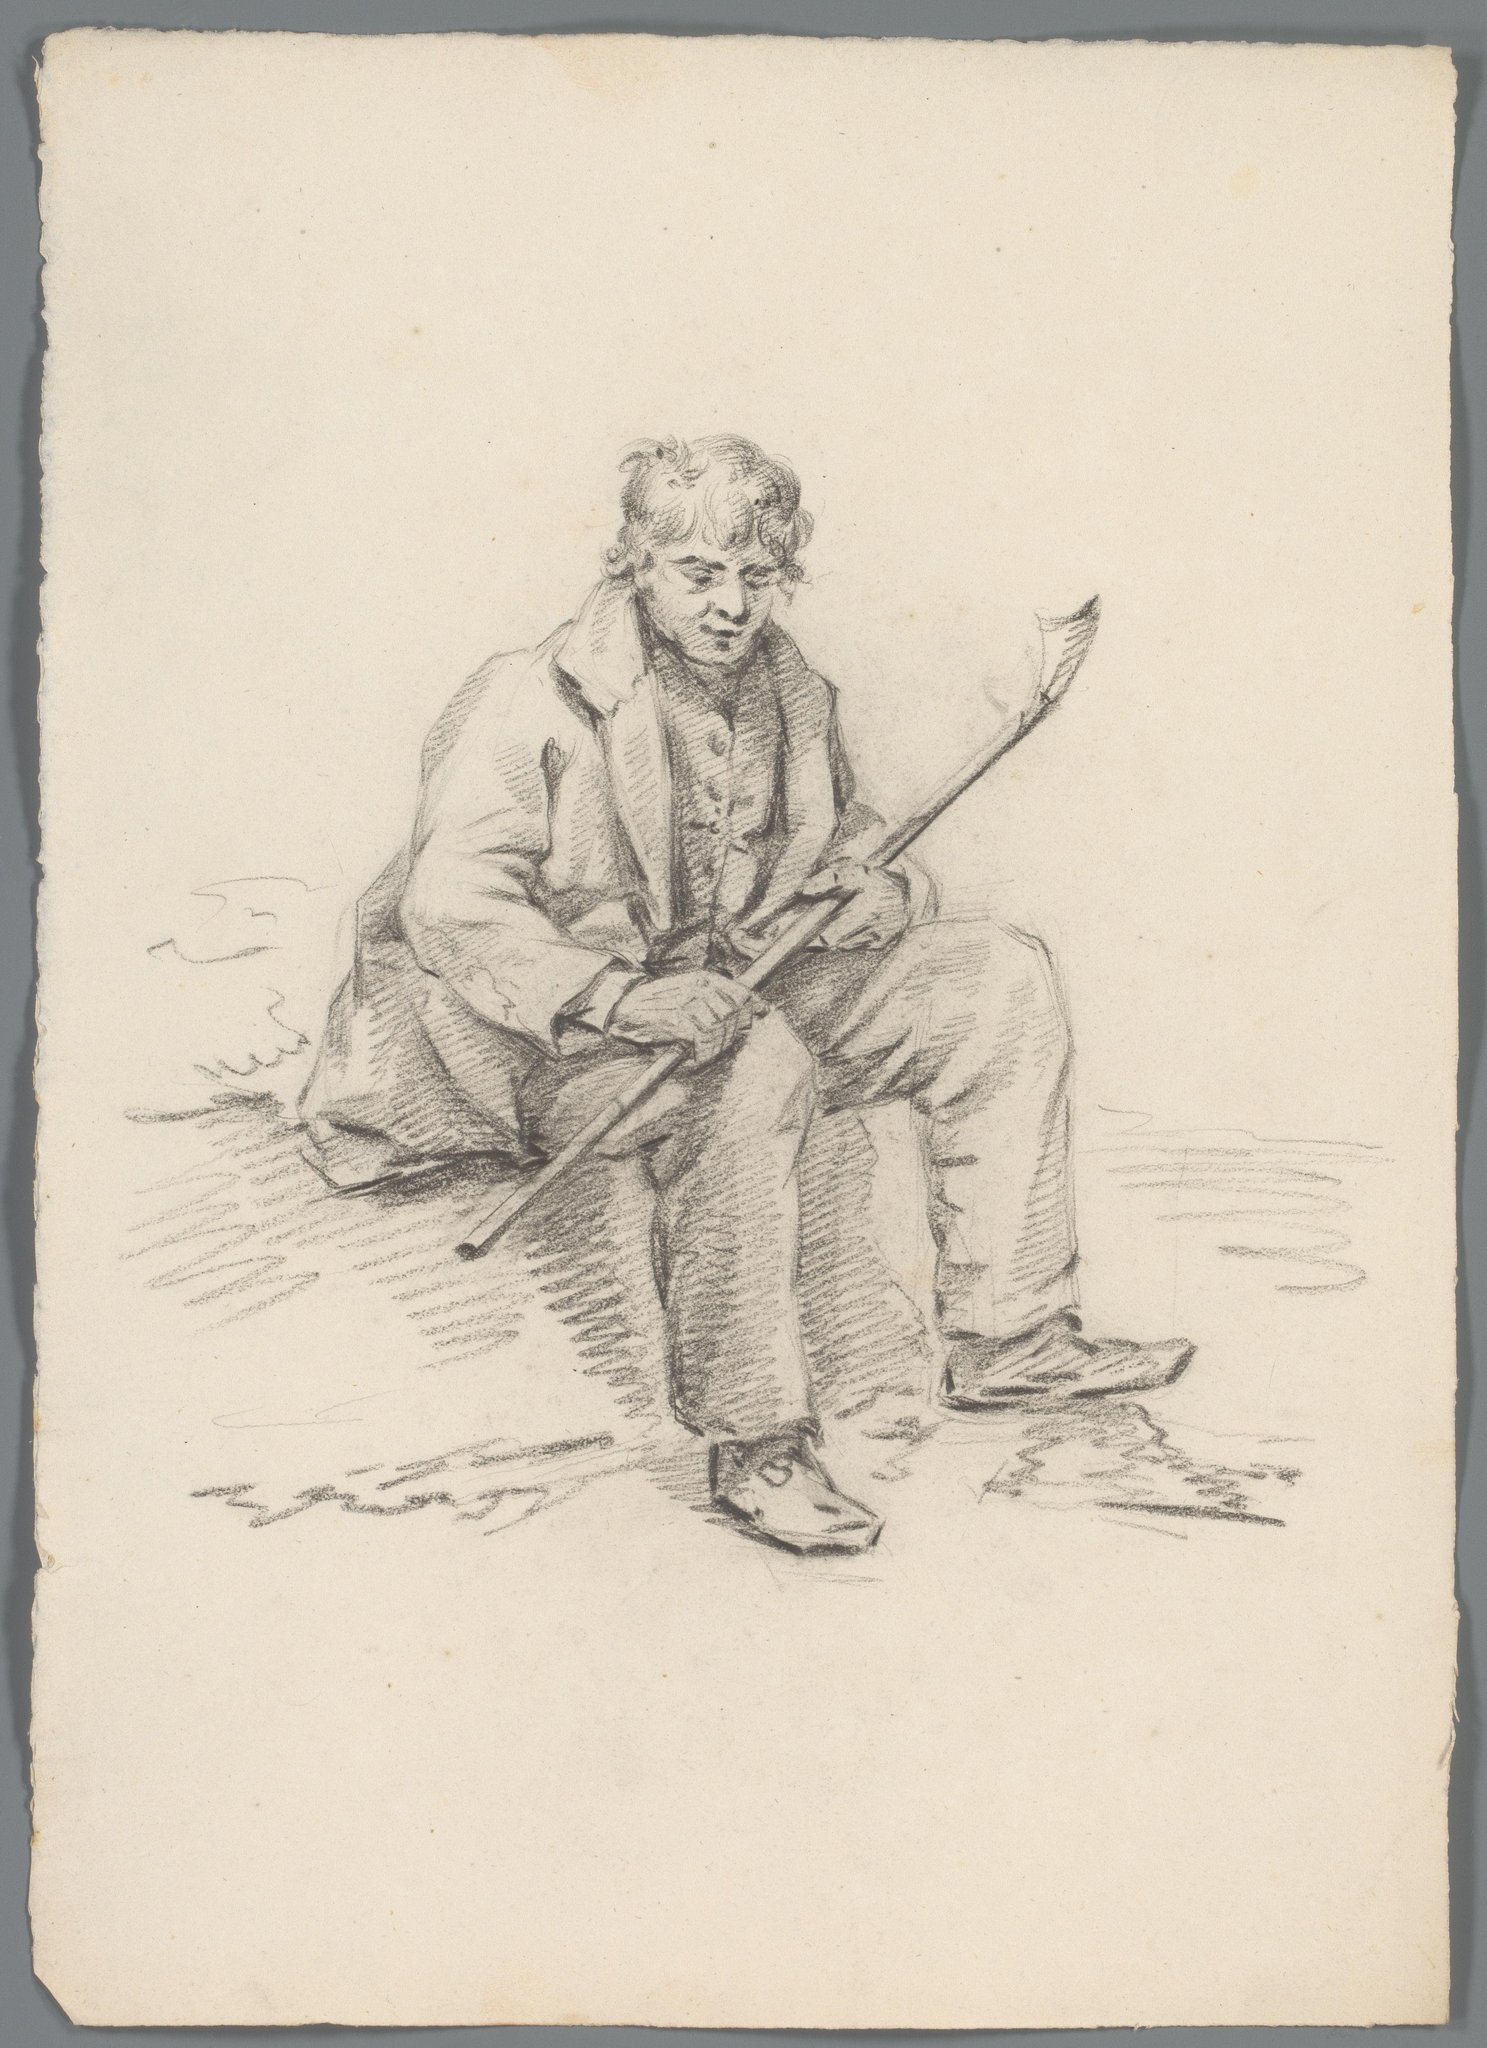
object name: drawing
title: Zittende man met wandelstok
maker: Anonymous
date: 1820-1830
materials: chalk, paper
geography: the hague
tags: sitting figure, walking-stick, staff, adult man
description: Tekeningen waarschijnlijk ontstaan bij het Haagse kunstgenootschap ‘Tot Nut der Tekenkunst’, waar twee keer per week tekenavonden werden georganiseerd met geklede modellen.